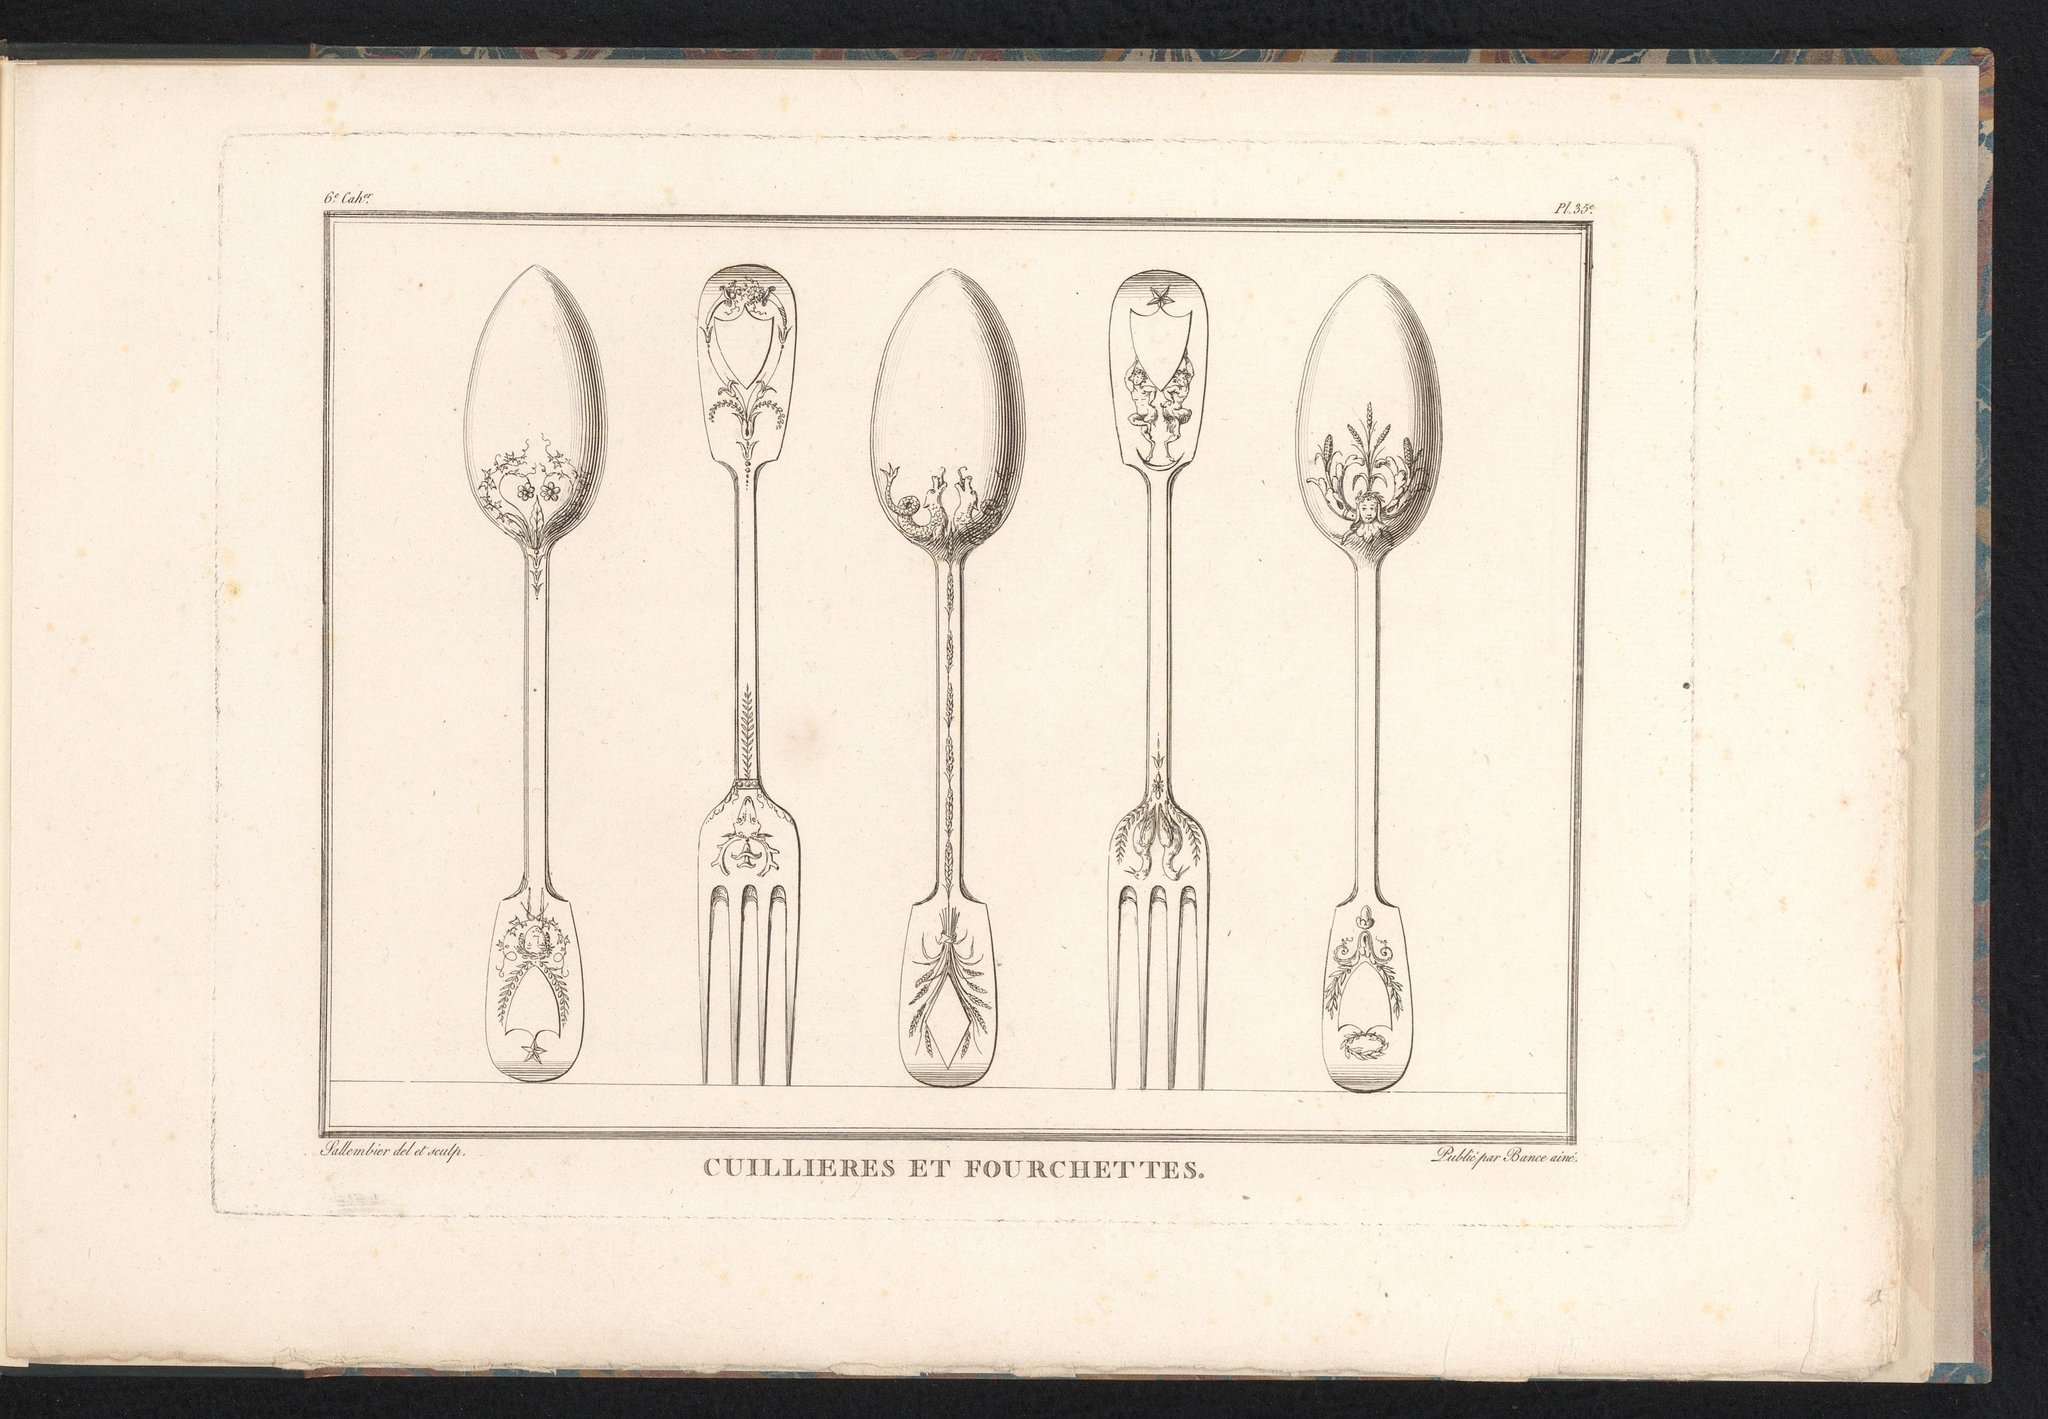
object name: album leaf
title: Lepels en vorken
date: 1805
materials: paper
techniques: etching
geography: paris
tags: fork, hoofed animals: deer, monsters of the sea, satyr(s) (in general), spoon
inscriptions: number: ‘6.e Cah.er’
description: Ontwerpen voor drie lepels en twee vorken, met onder meer een hert, zeemonsters, saters en vogels. Prent maakt deel uit van een album.